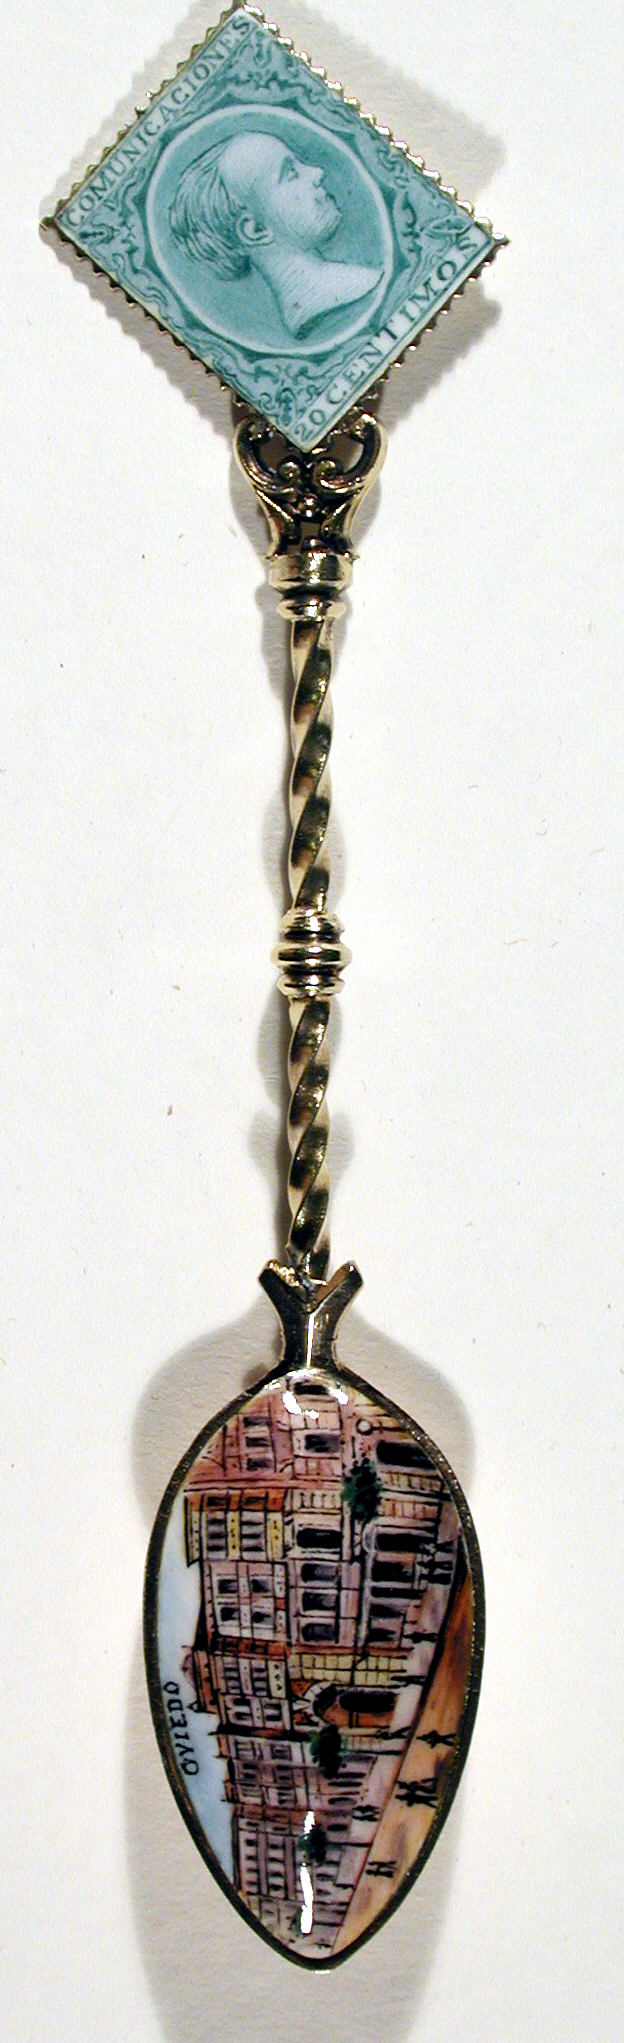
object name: souvenir spoon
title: Souvenir spoon with street scene in Oviedo and finial in form of a postage stamp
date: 1867-1900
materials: enamel, gilt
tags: buildings